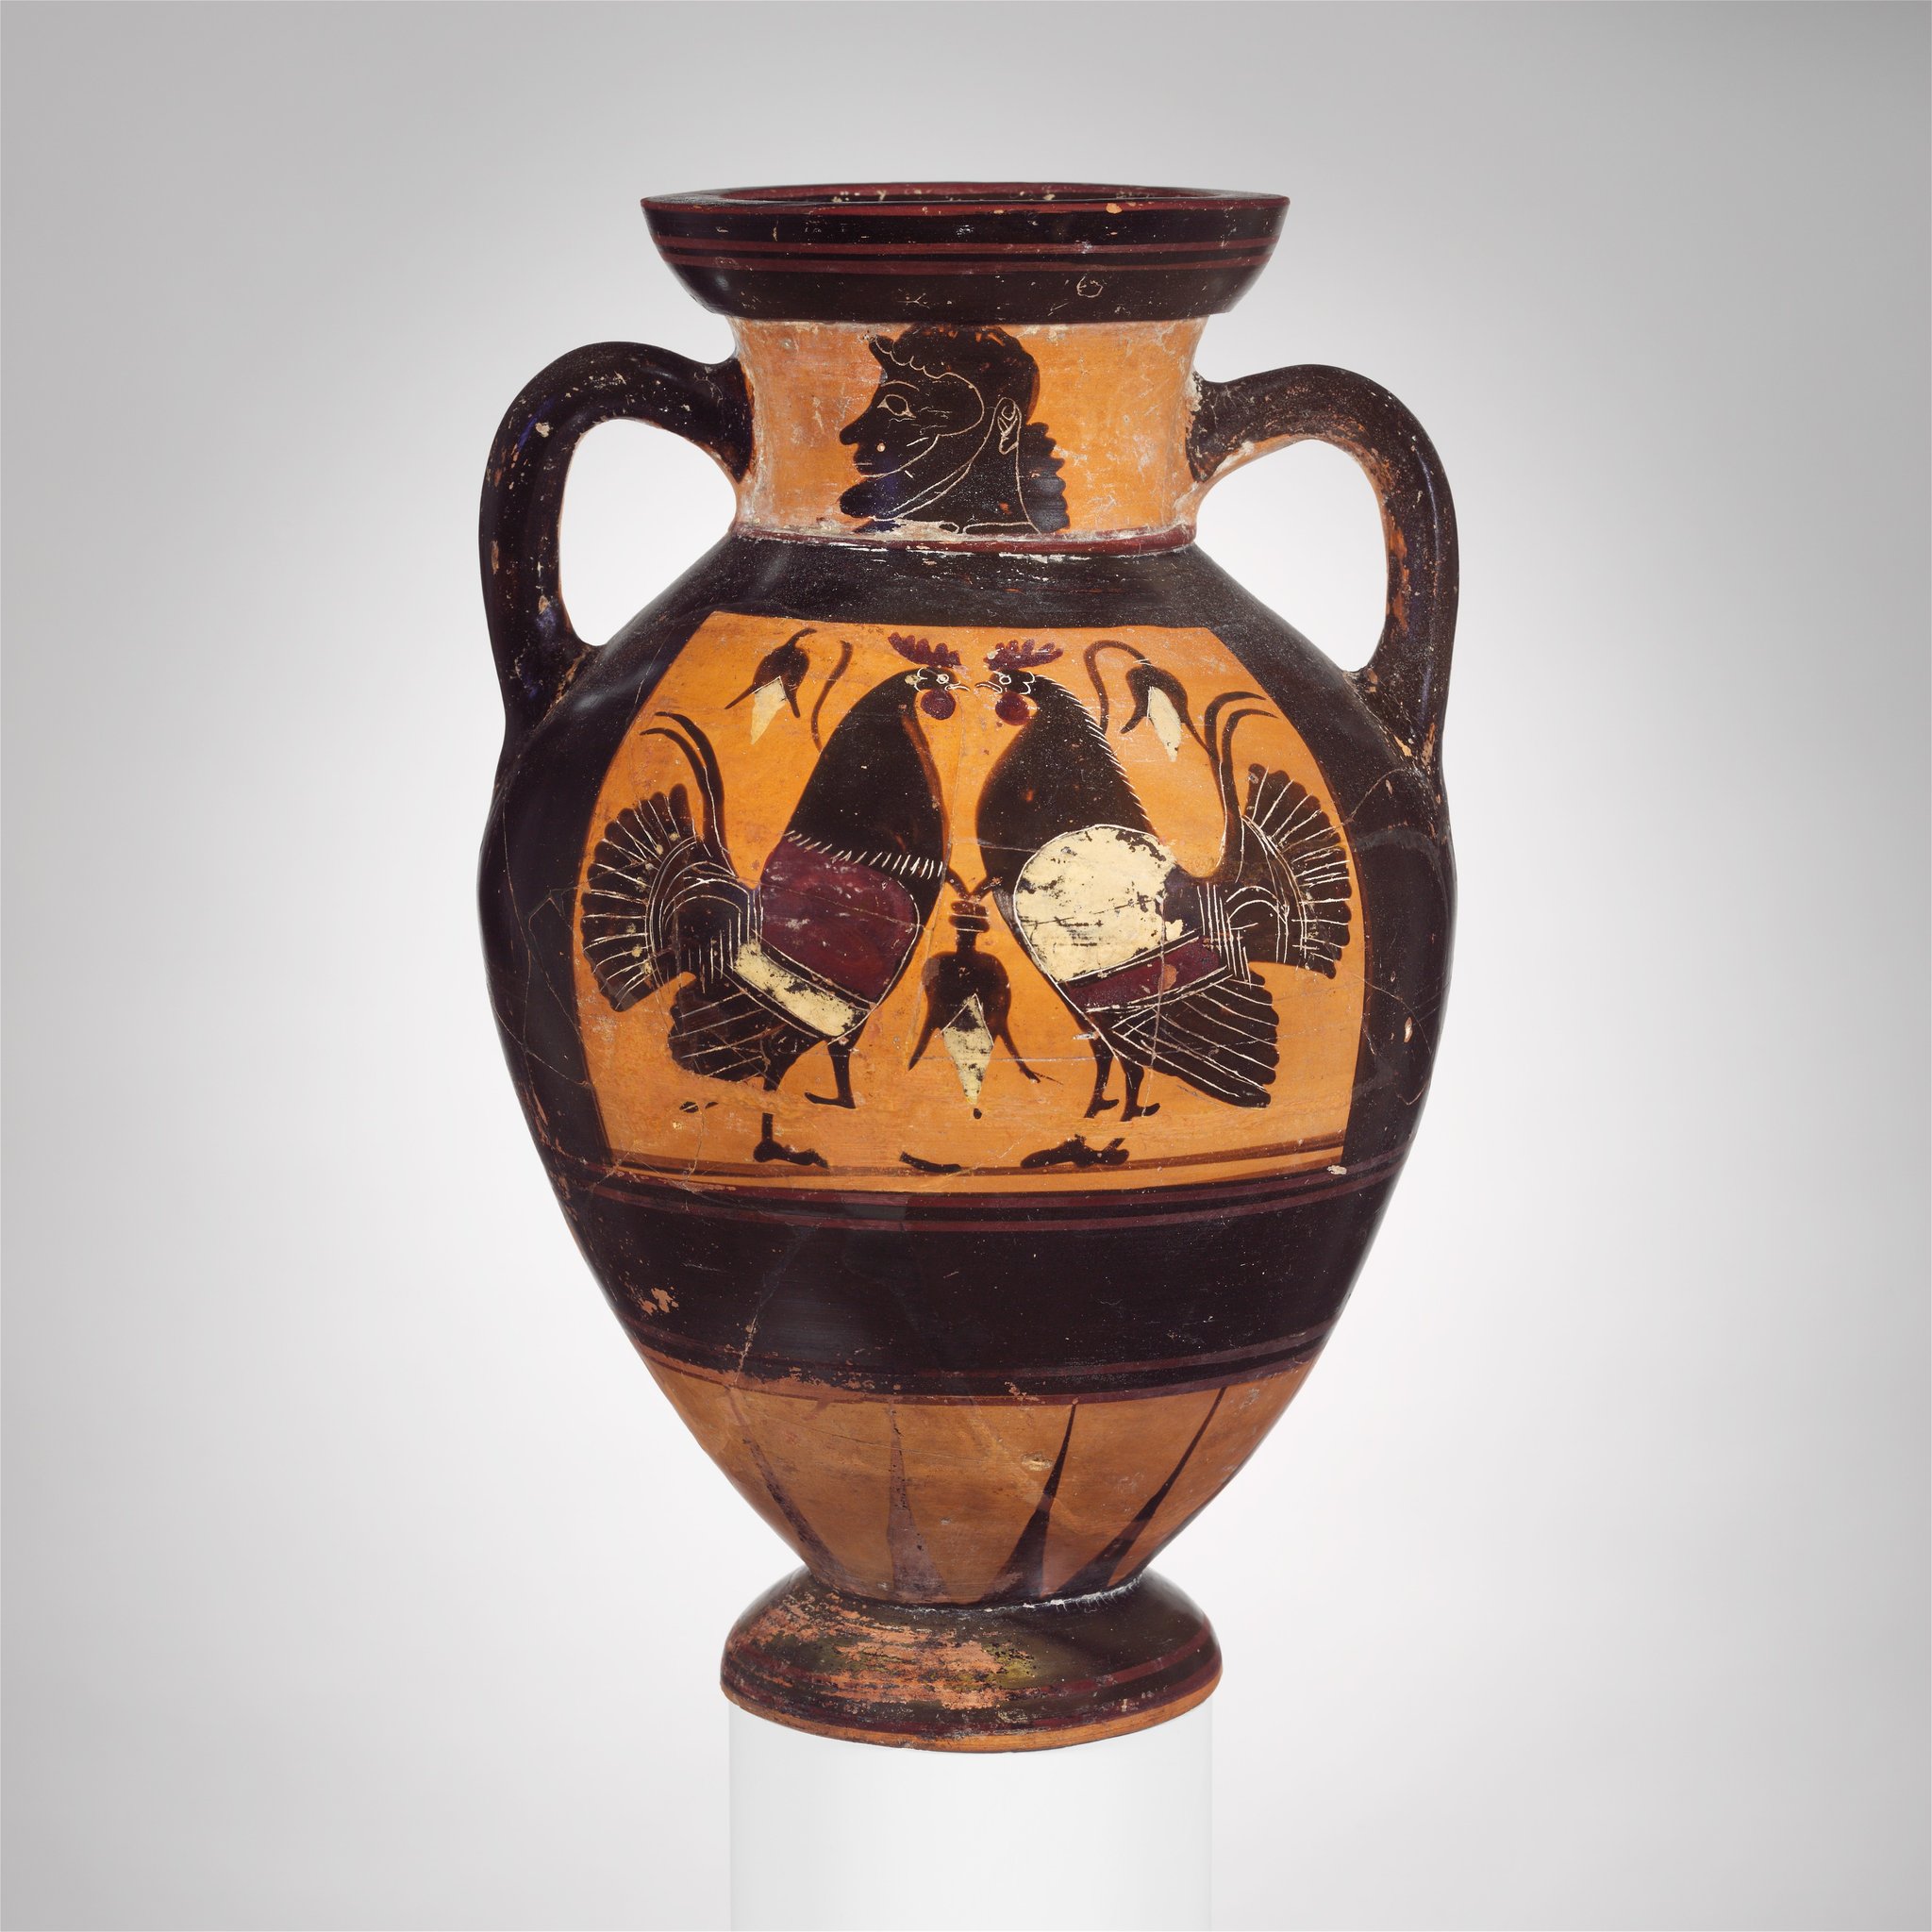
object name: neck amphora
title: Terracotta neck-amphora (jar)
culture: greek, attic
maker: painter of london b 76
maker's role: artist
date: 570-560 BCE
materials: terracotta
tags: birds,shields,men,roosters